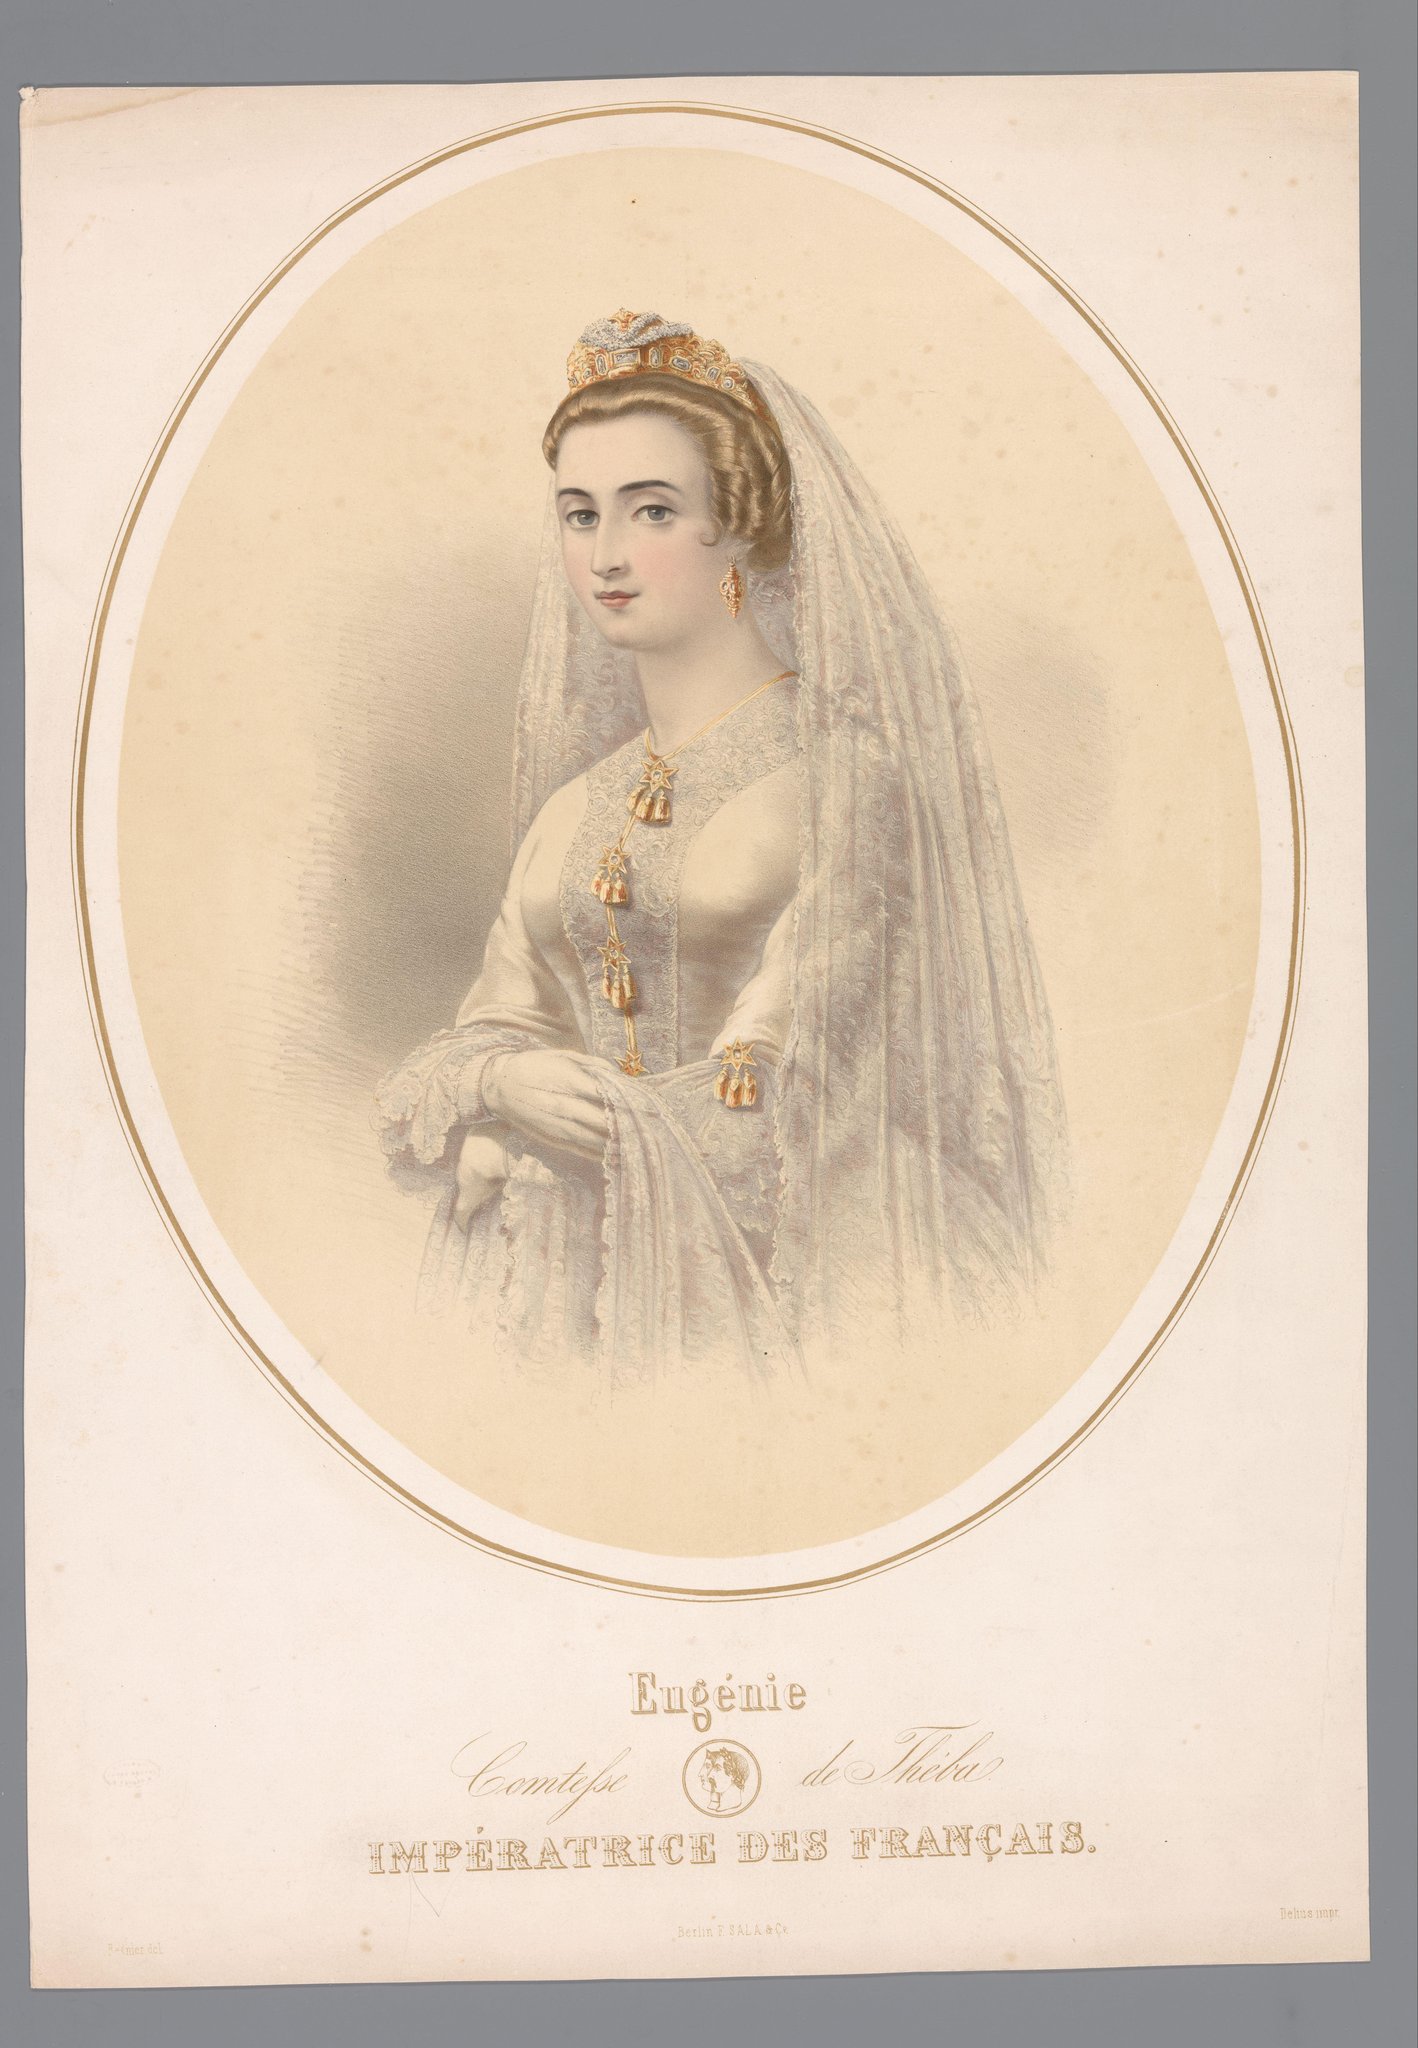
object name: print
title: Portret van Eugénie, keizerin van Frankrijk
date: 1840-1866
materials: paper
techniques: hand coloring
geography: berlin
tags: sevilla, historical persons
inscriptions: check stamp: ‘F. Sala & Co. / Kunst-Verlag / Berlin’, collector's mark: Lugt 2228